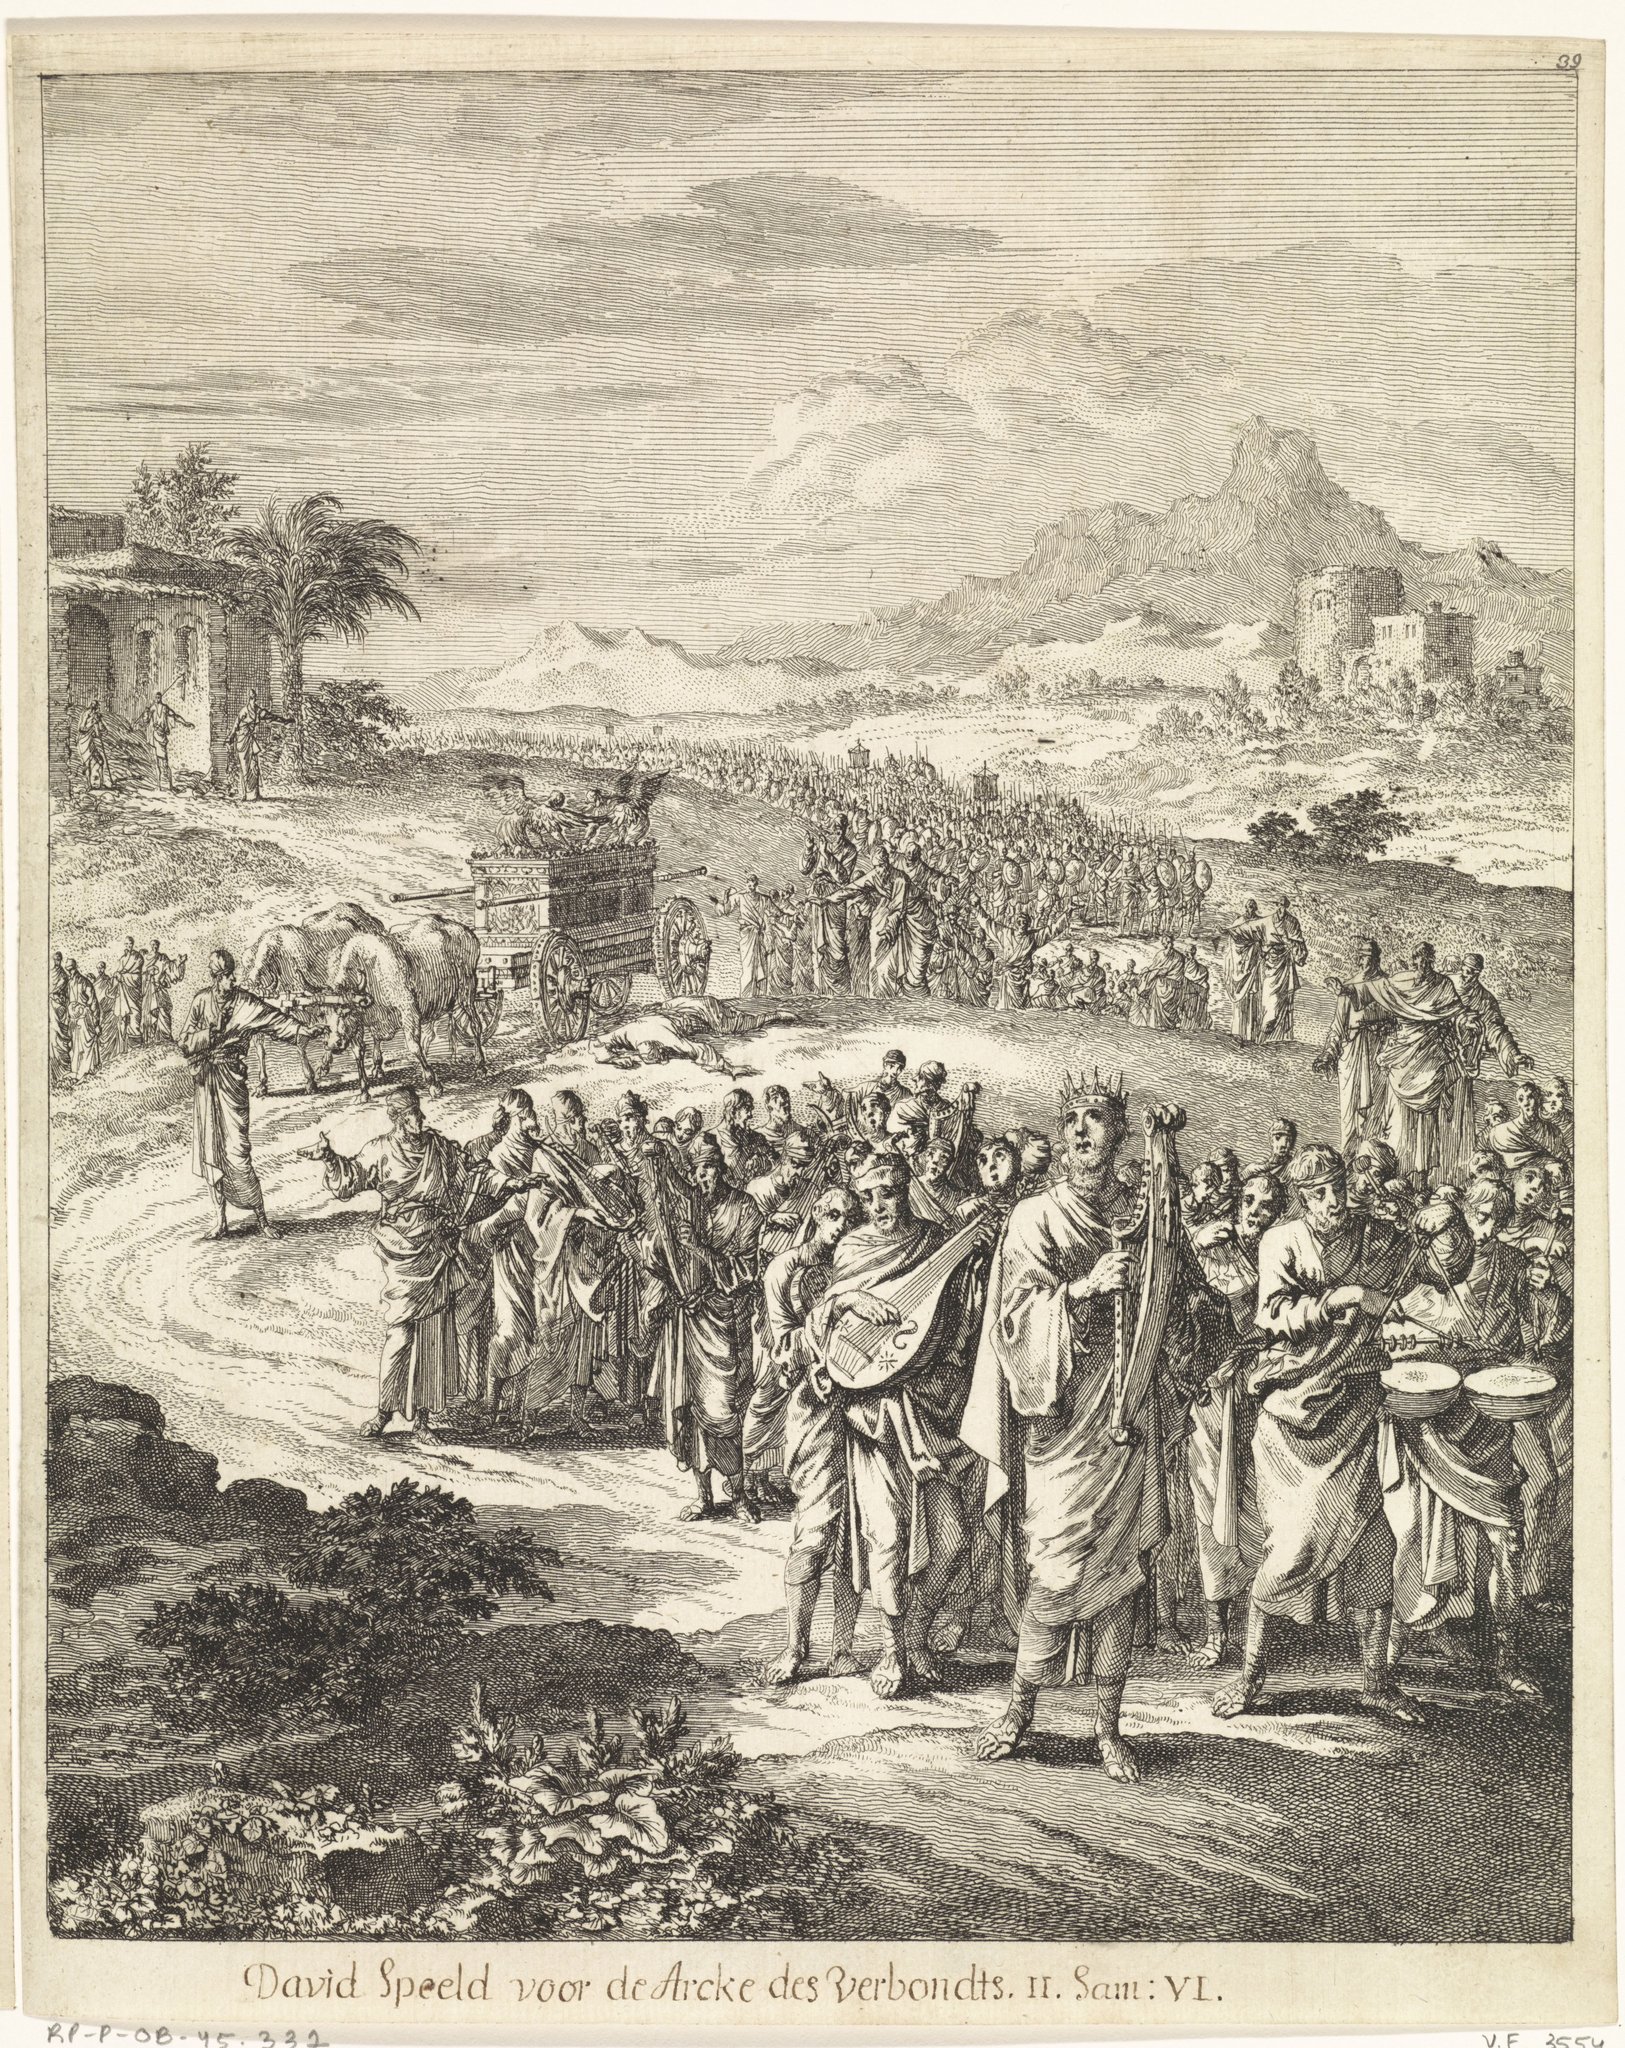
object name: print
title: Ark van God overgebracht naar Jeruzalem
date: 1708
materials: paper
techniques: etching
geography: amsterdam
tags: the ark is placed on a cart driven by the sons of abinadab; david and the people dance and make music before the ark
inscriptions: collector's mark: Lugt 2228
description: Proefdruk van een prent welke is opgenomen als illustratie in: Historiae Celebriores Veteris Testamenti. Christoph Weigel, 1708.